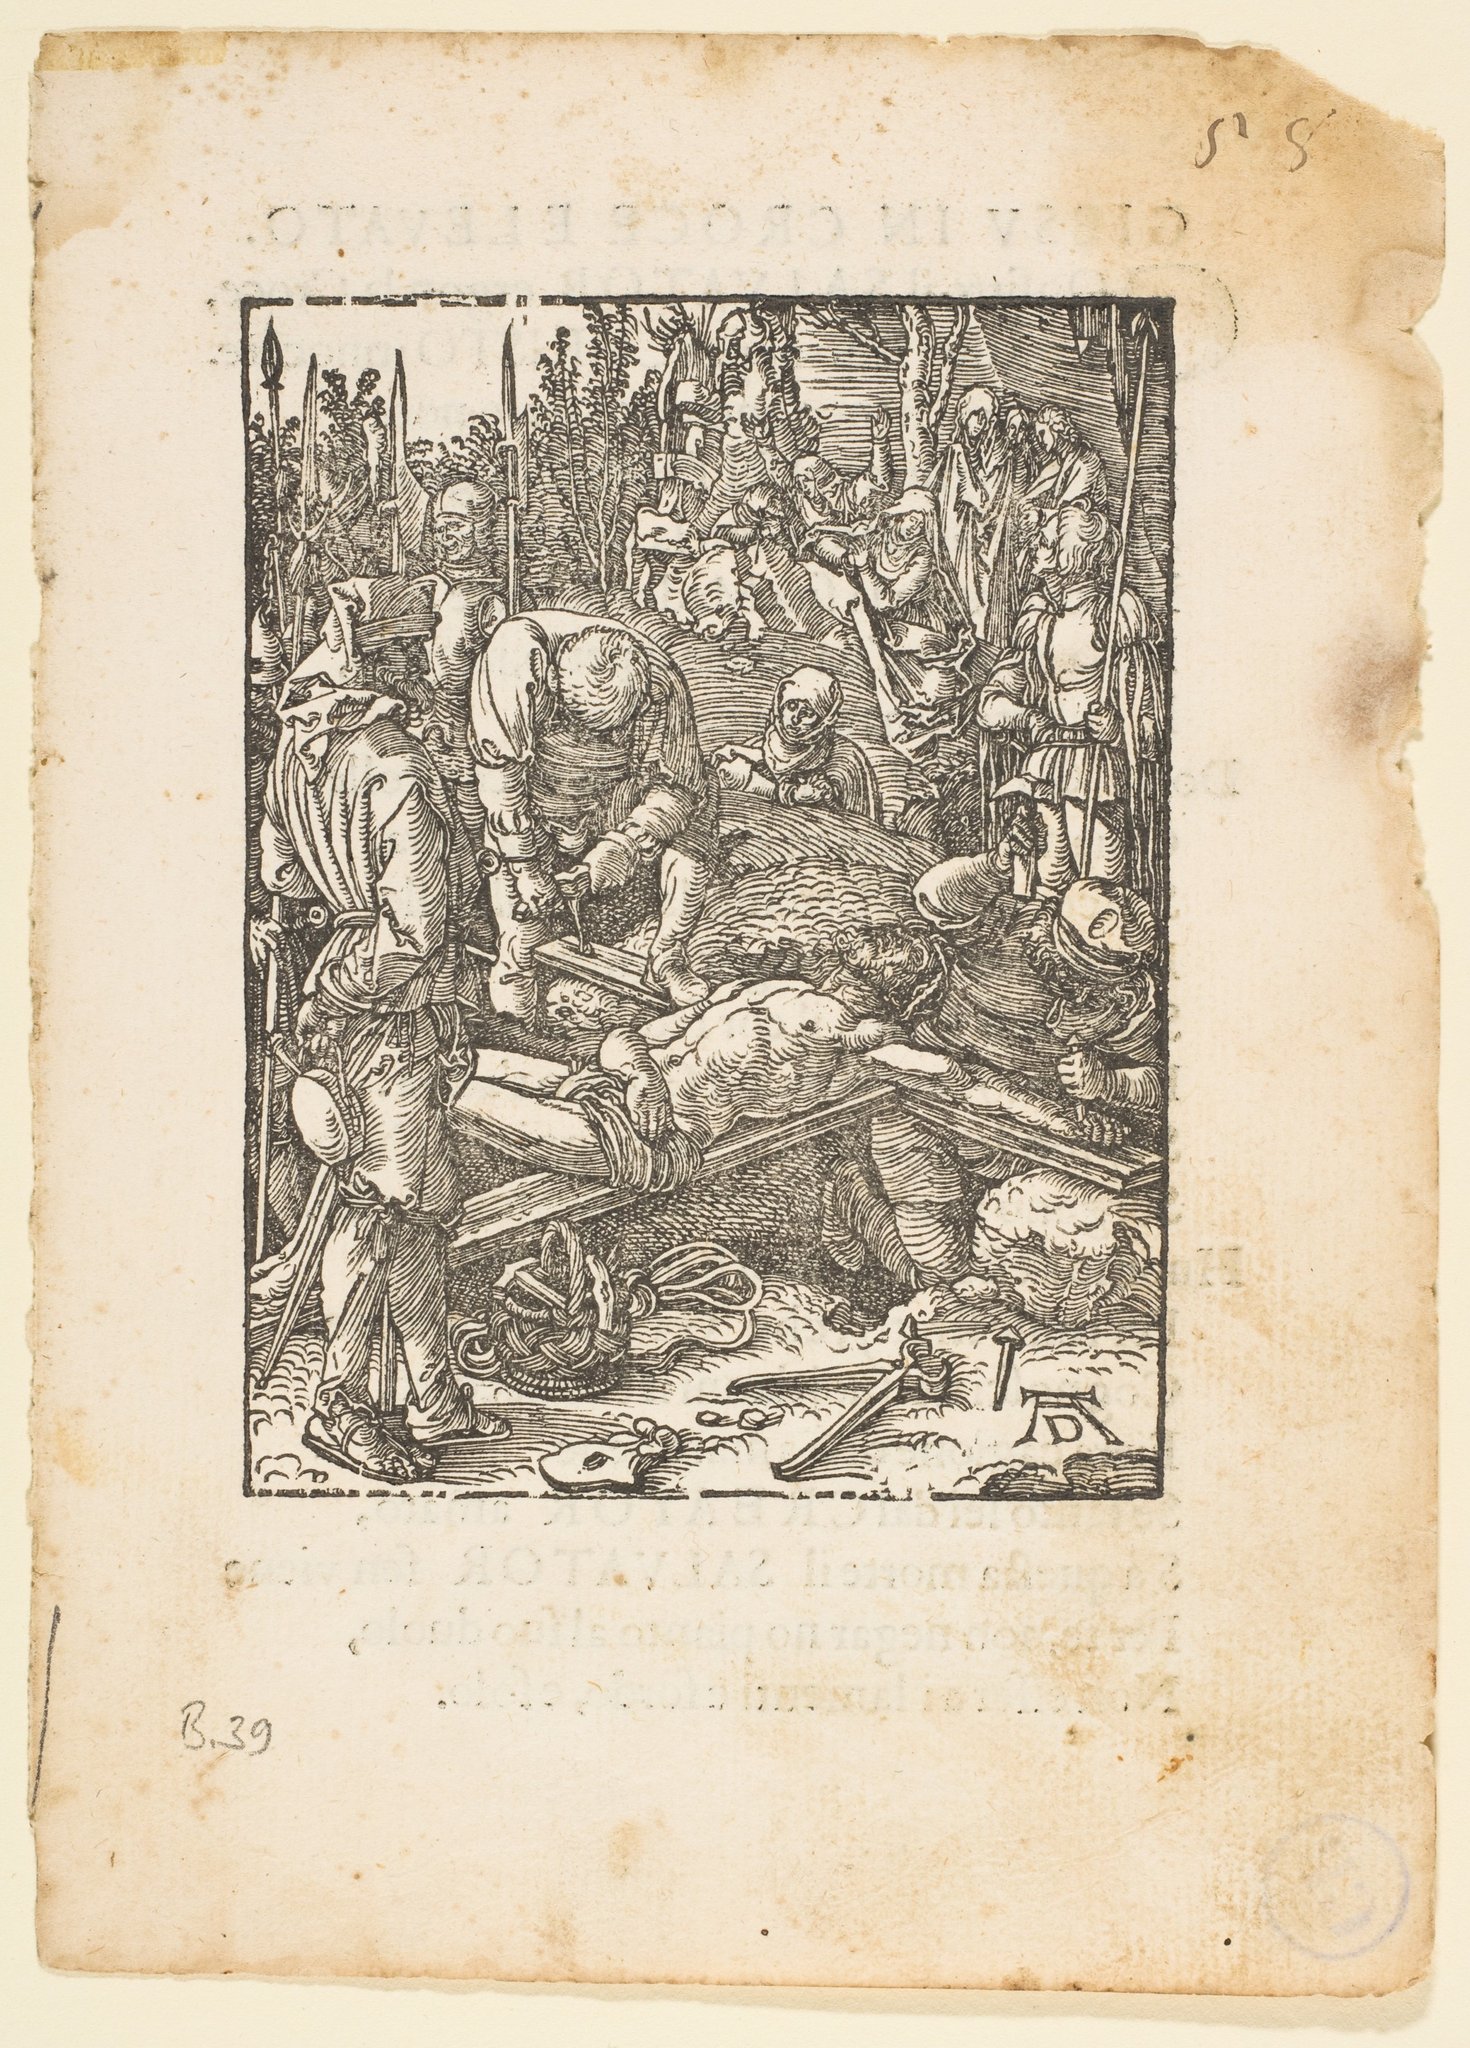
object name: print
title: Christ Nailed to The Cross, from "The Small Passion", edition Venice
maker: albrecht dürer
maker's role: artist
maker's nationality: german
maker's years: 1471-1528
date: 1612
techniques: woodcut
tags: christ,crucifixion